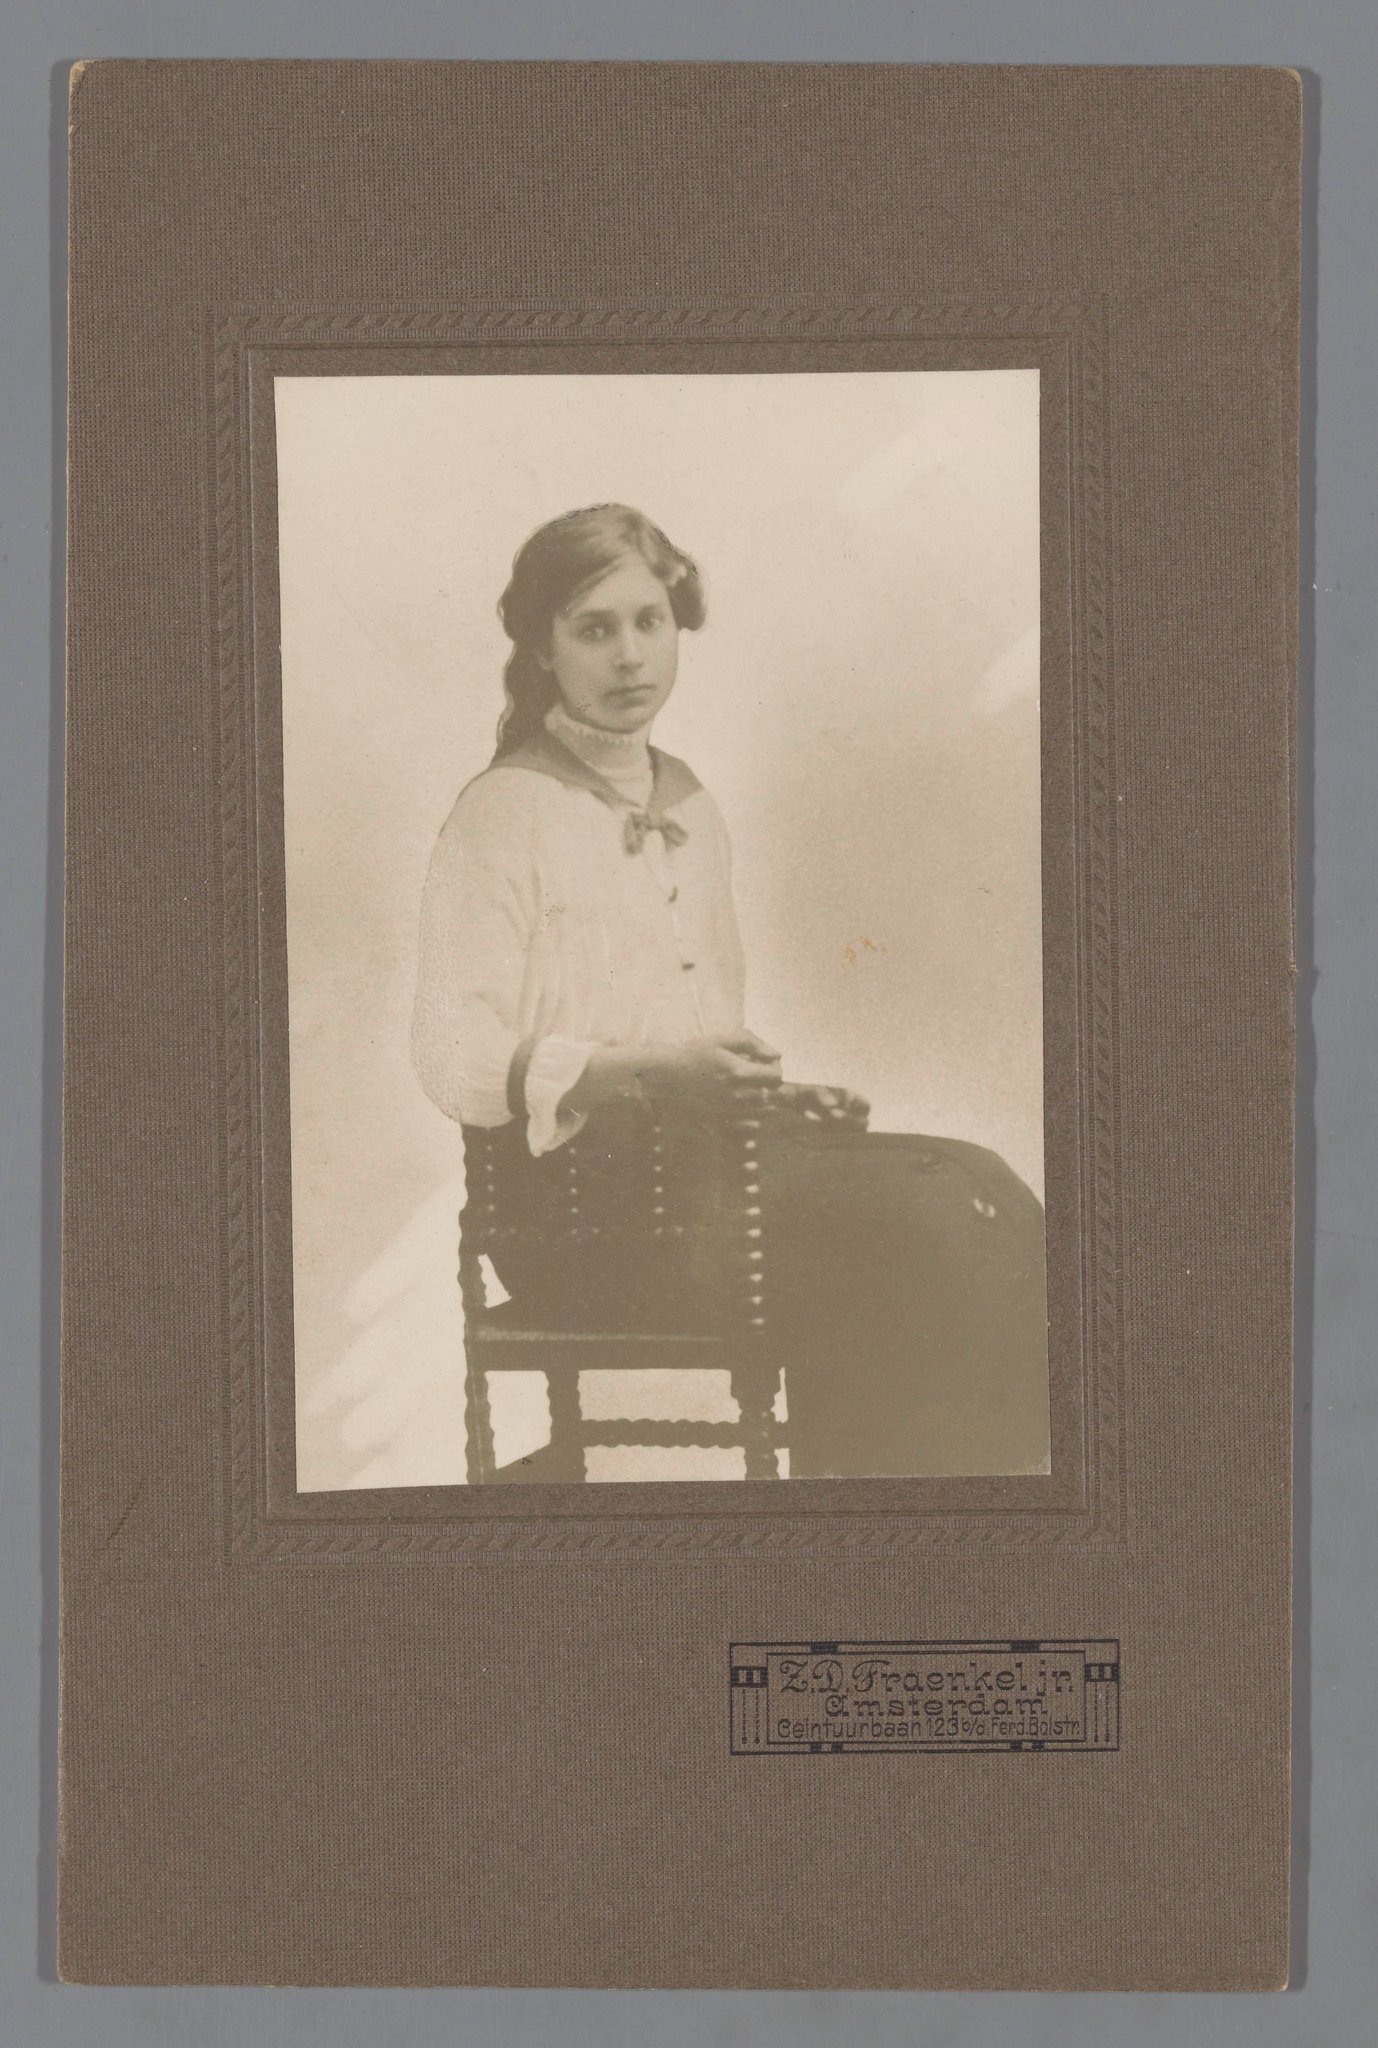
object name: cabinet photograph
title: Portret van een onbekende vrouw op een stoel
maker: zacharias fraenkel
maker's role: fotograaf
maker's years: 1878-1942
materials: cardboard, photographic support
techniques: gelatin silver print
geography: amsterdam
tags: adult woman, studio requisites ~ photographer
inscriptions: name: ‘Z.D. Fraenkel jr. Amsterdam Ceintuurbaan 123 b/d. Ferd. Bolstr.’